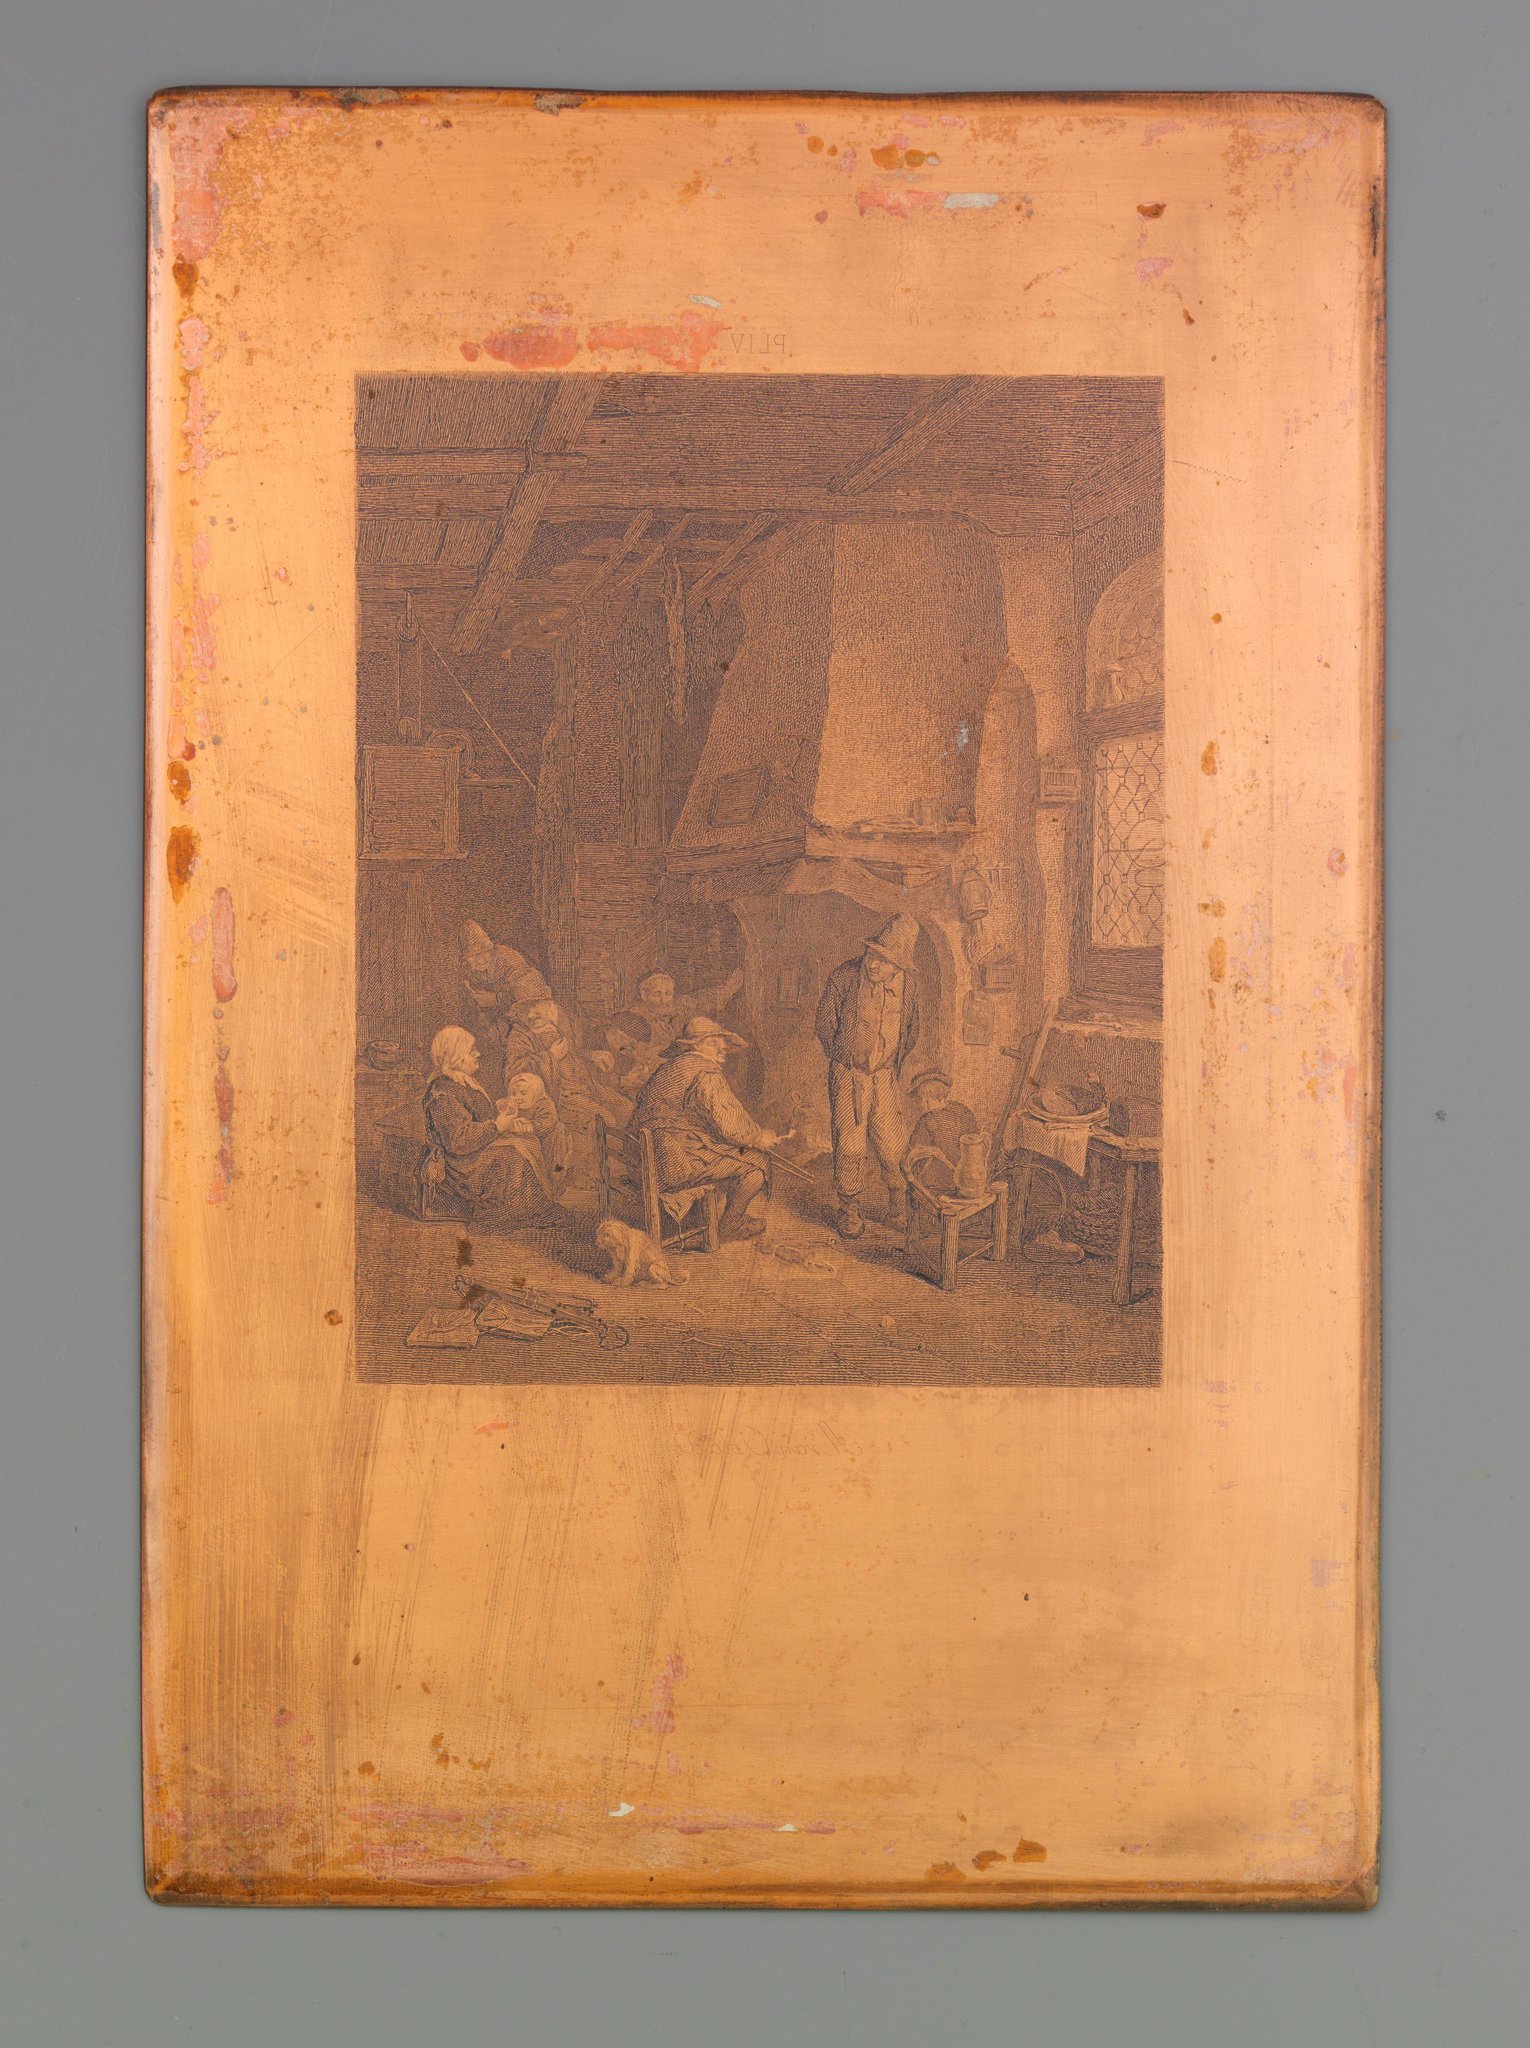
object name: copper plate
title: Boereninterieur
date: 1823-1900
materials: copper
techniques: etching